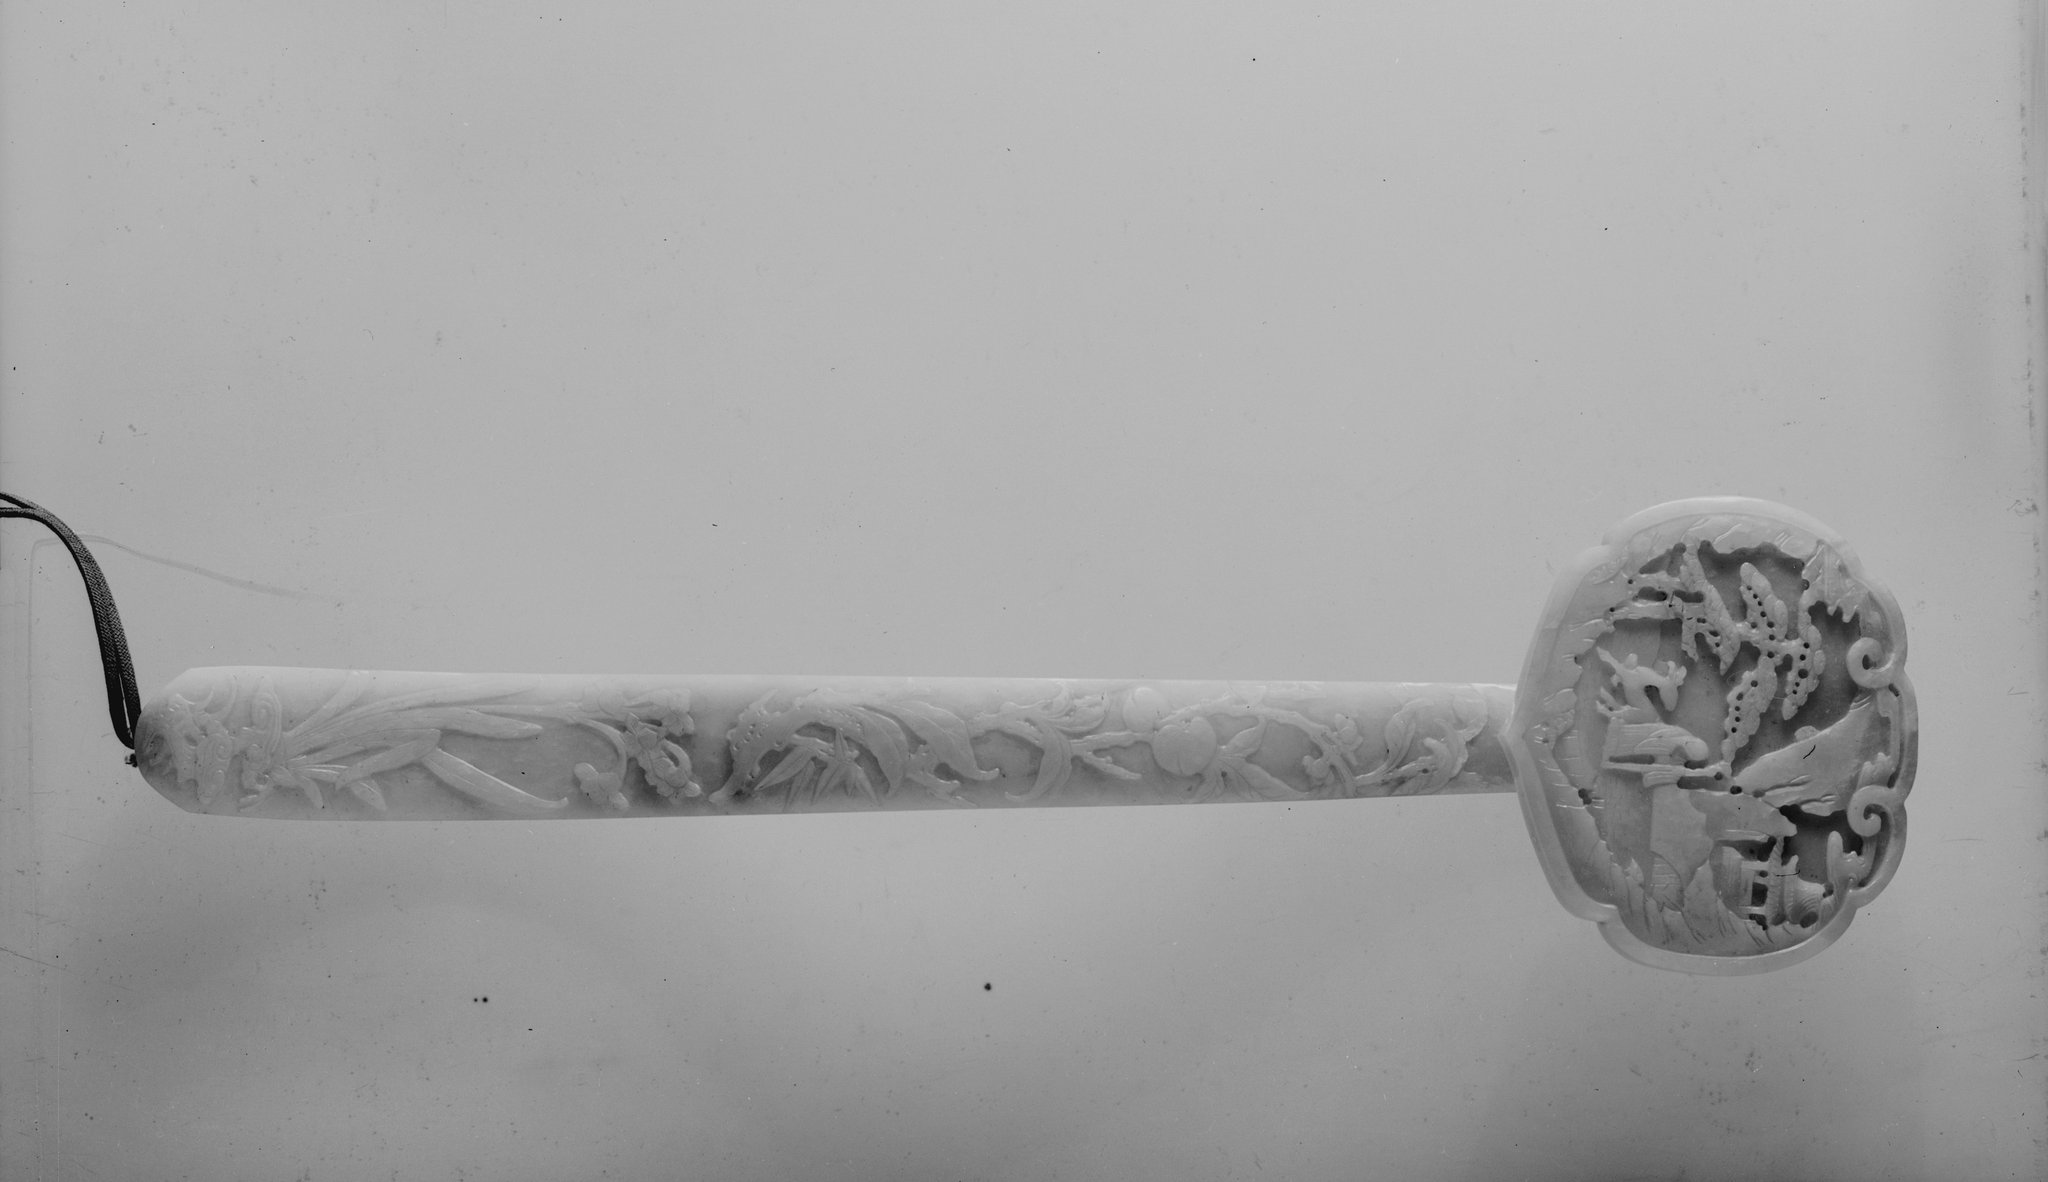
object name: sceptre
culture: chinese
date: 1736-1795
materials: jade